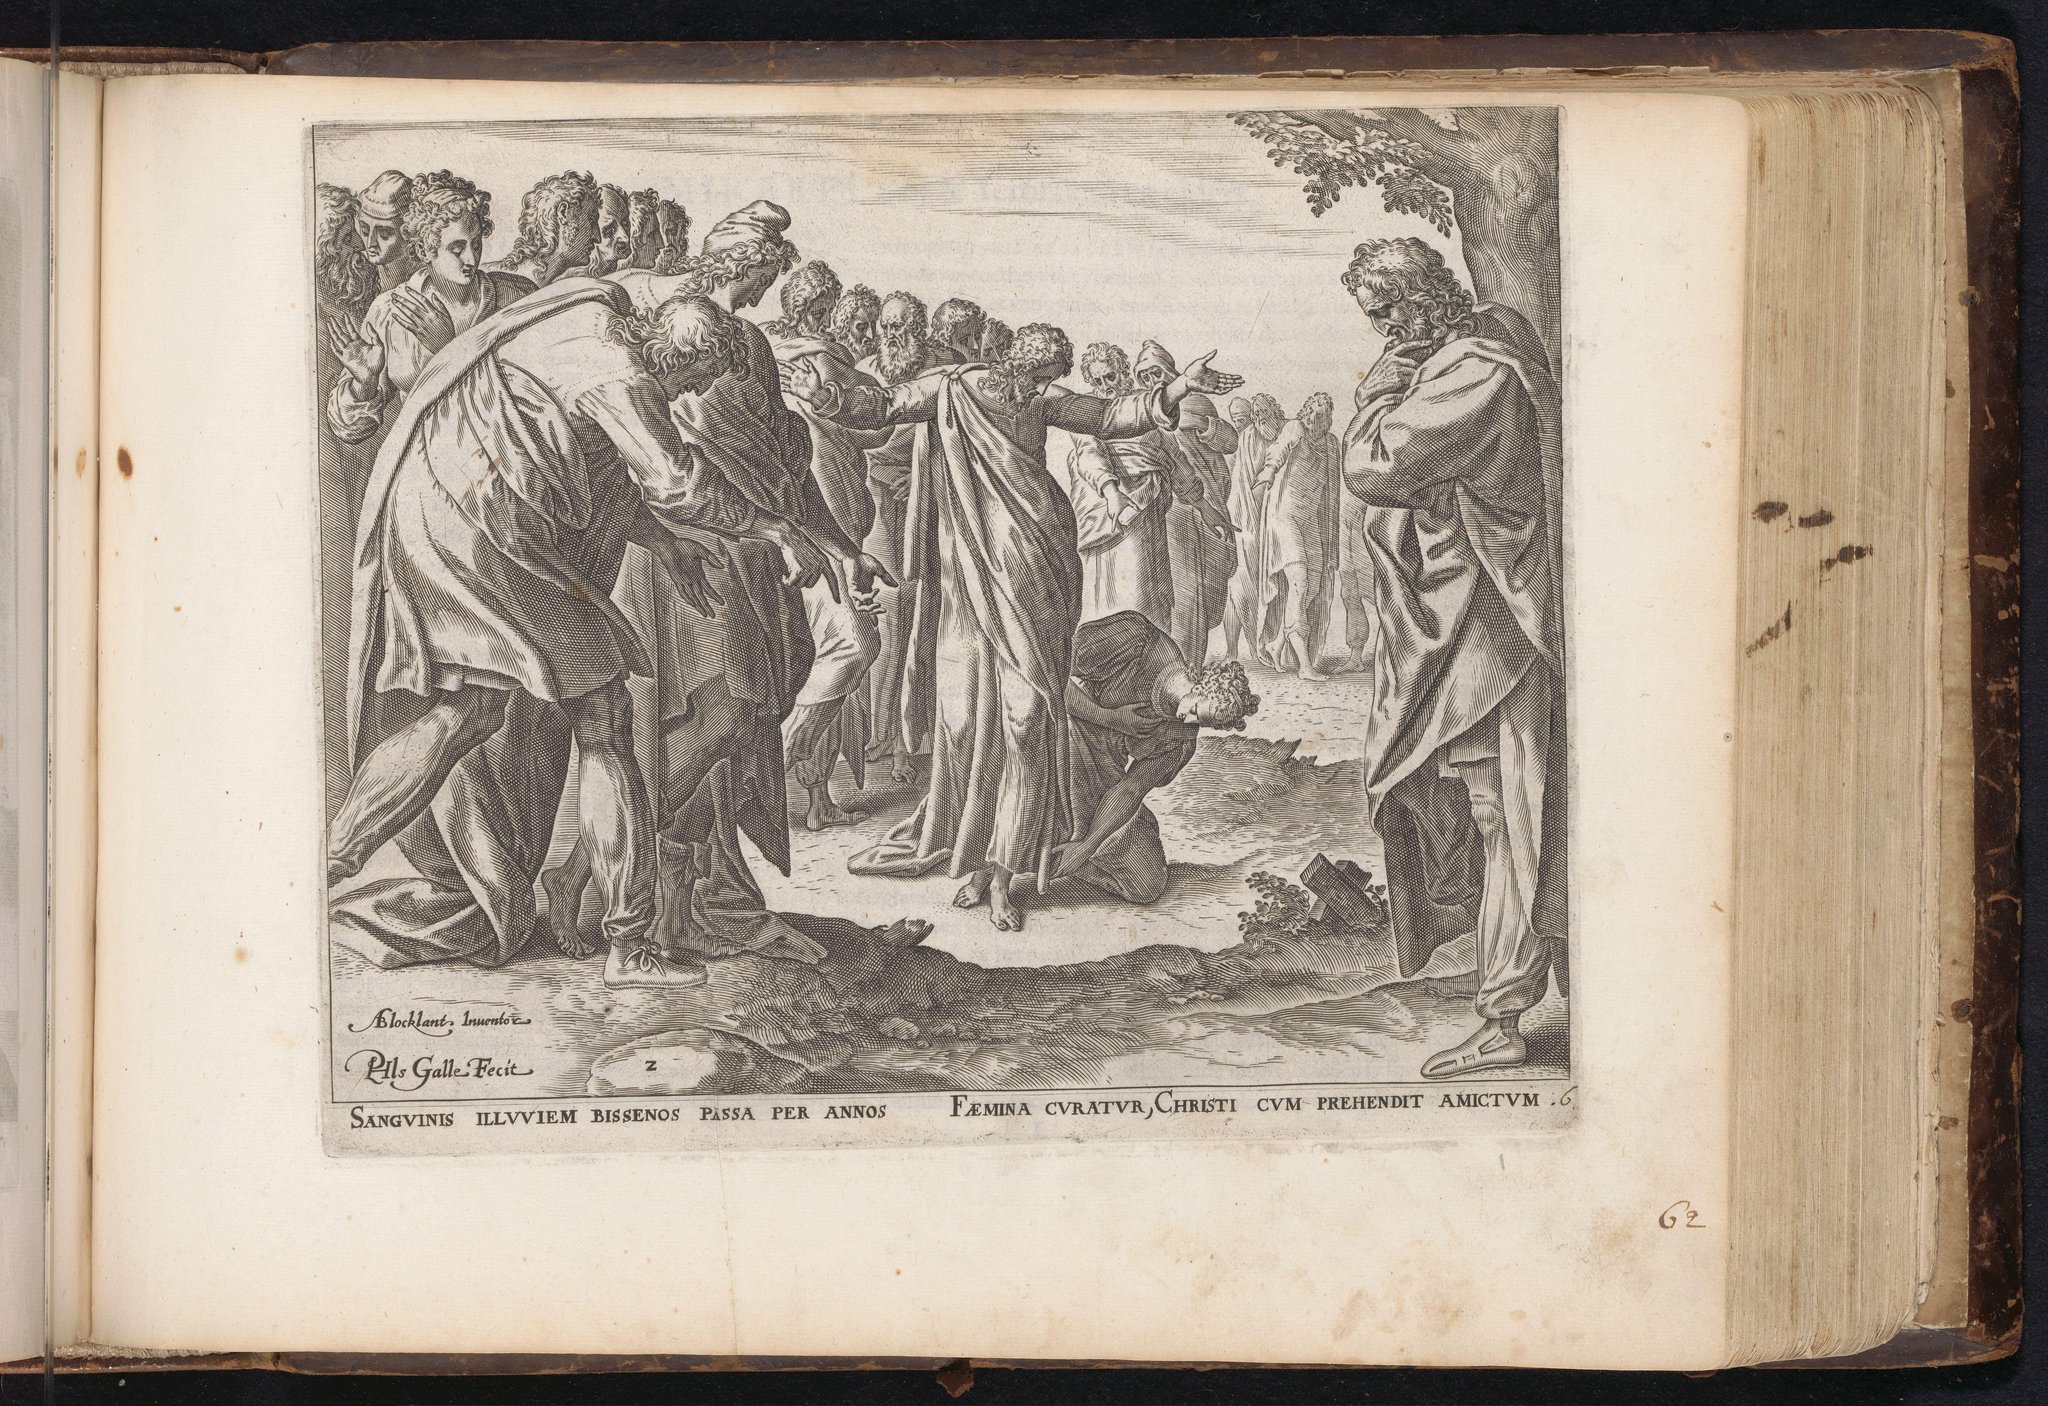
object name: album leaf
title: Christus geneest een vrouw die aan bloedverlies lijdt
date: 1575-1581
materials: paper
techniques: engraving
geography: antwerp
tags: healing of a woman with an issue of blood: she kneels before christ after having touched his robe (matthew 9:20-22; mark 5:25-34; luke 8:43-48)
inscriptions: number: ‘62’, serial number: ‘6’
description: Christus staat tussen een groep mannen. Een zieke vrouw knielt naast hem op de grond en raakt de zoom van zijn bovenkleed aan om te kunnen genezen van haar ziekte. Onder de voorstelling een verwijzing in het Latijn naar de Bijbeltekst. Deze prent maakt deel uit van een album.